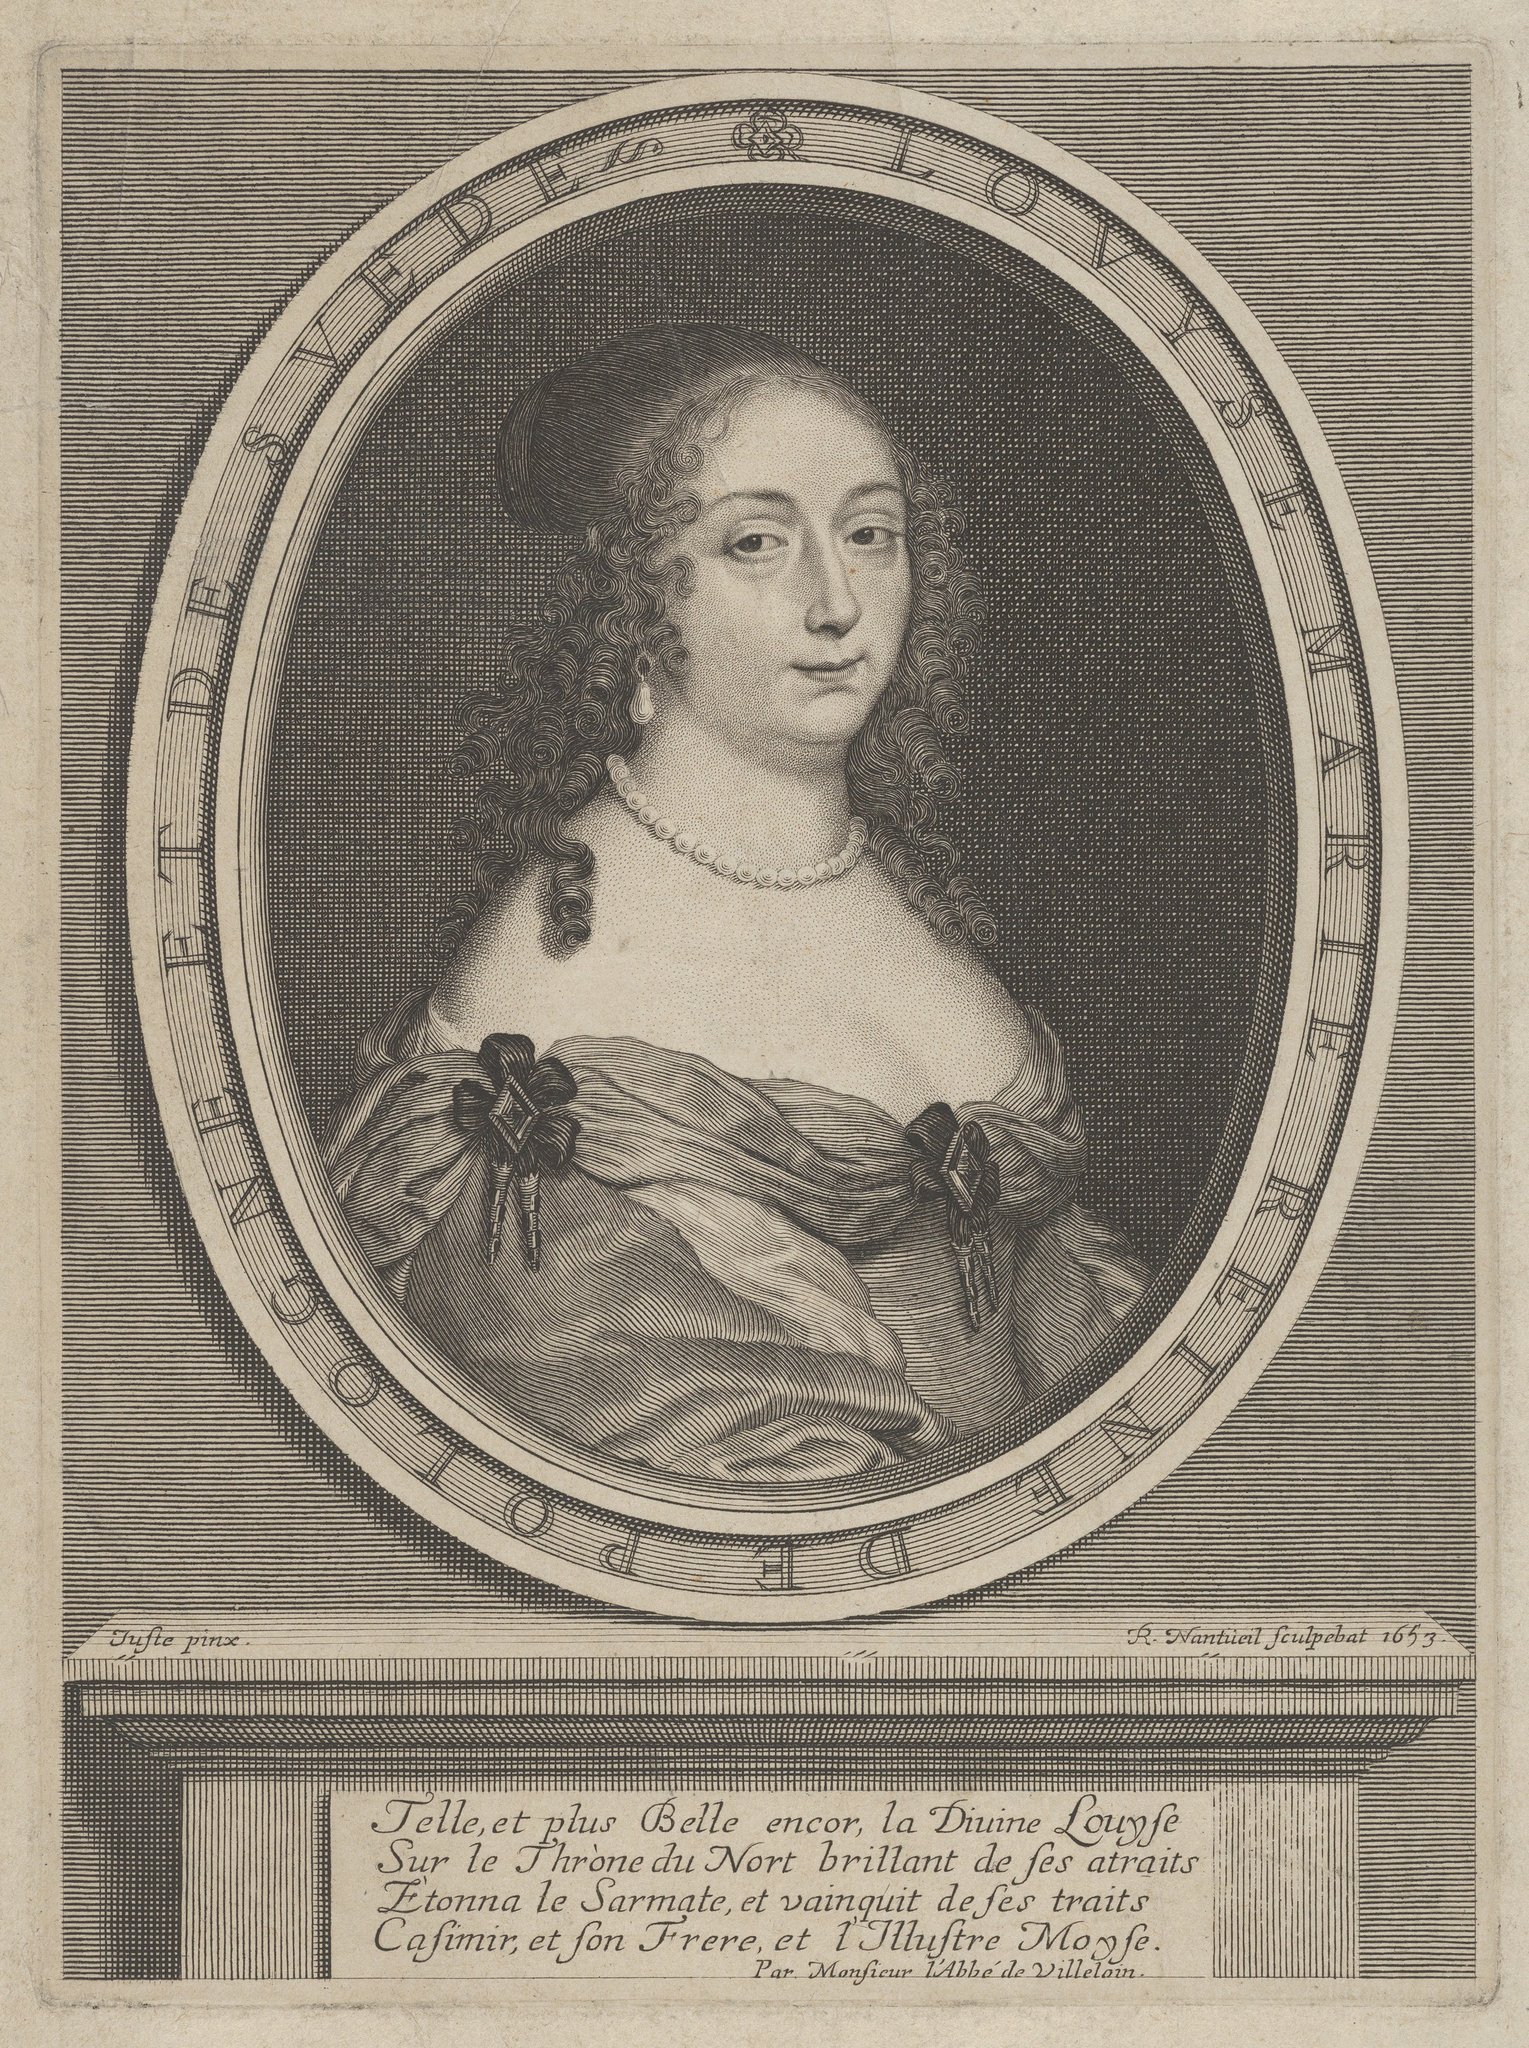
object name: print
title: Portrait of Louise Marie, Queen of Poland and Sweden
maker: robert nanteuil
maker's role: artist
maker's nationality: french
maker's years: 1623-1678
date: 1653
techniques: engraving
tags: portraits,women